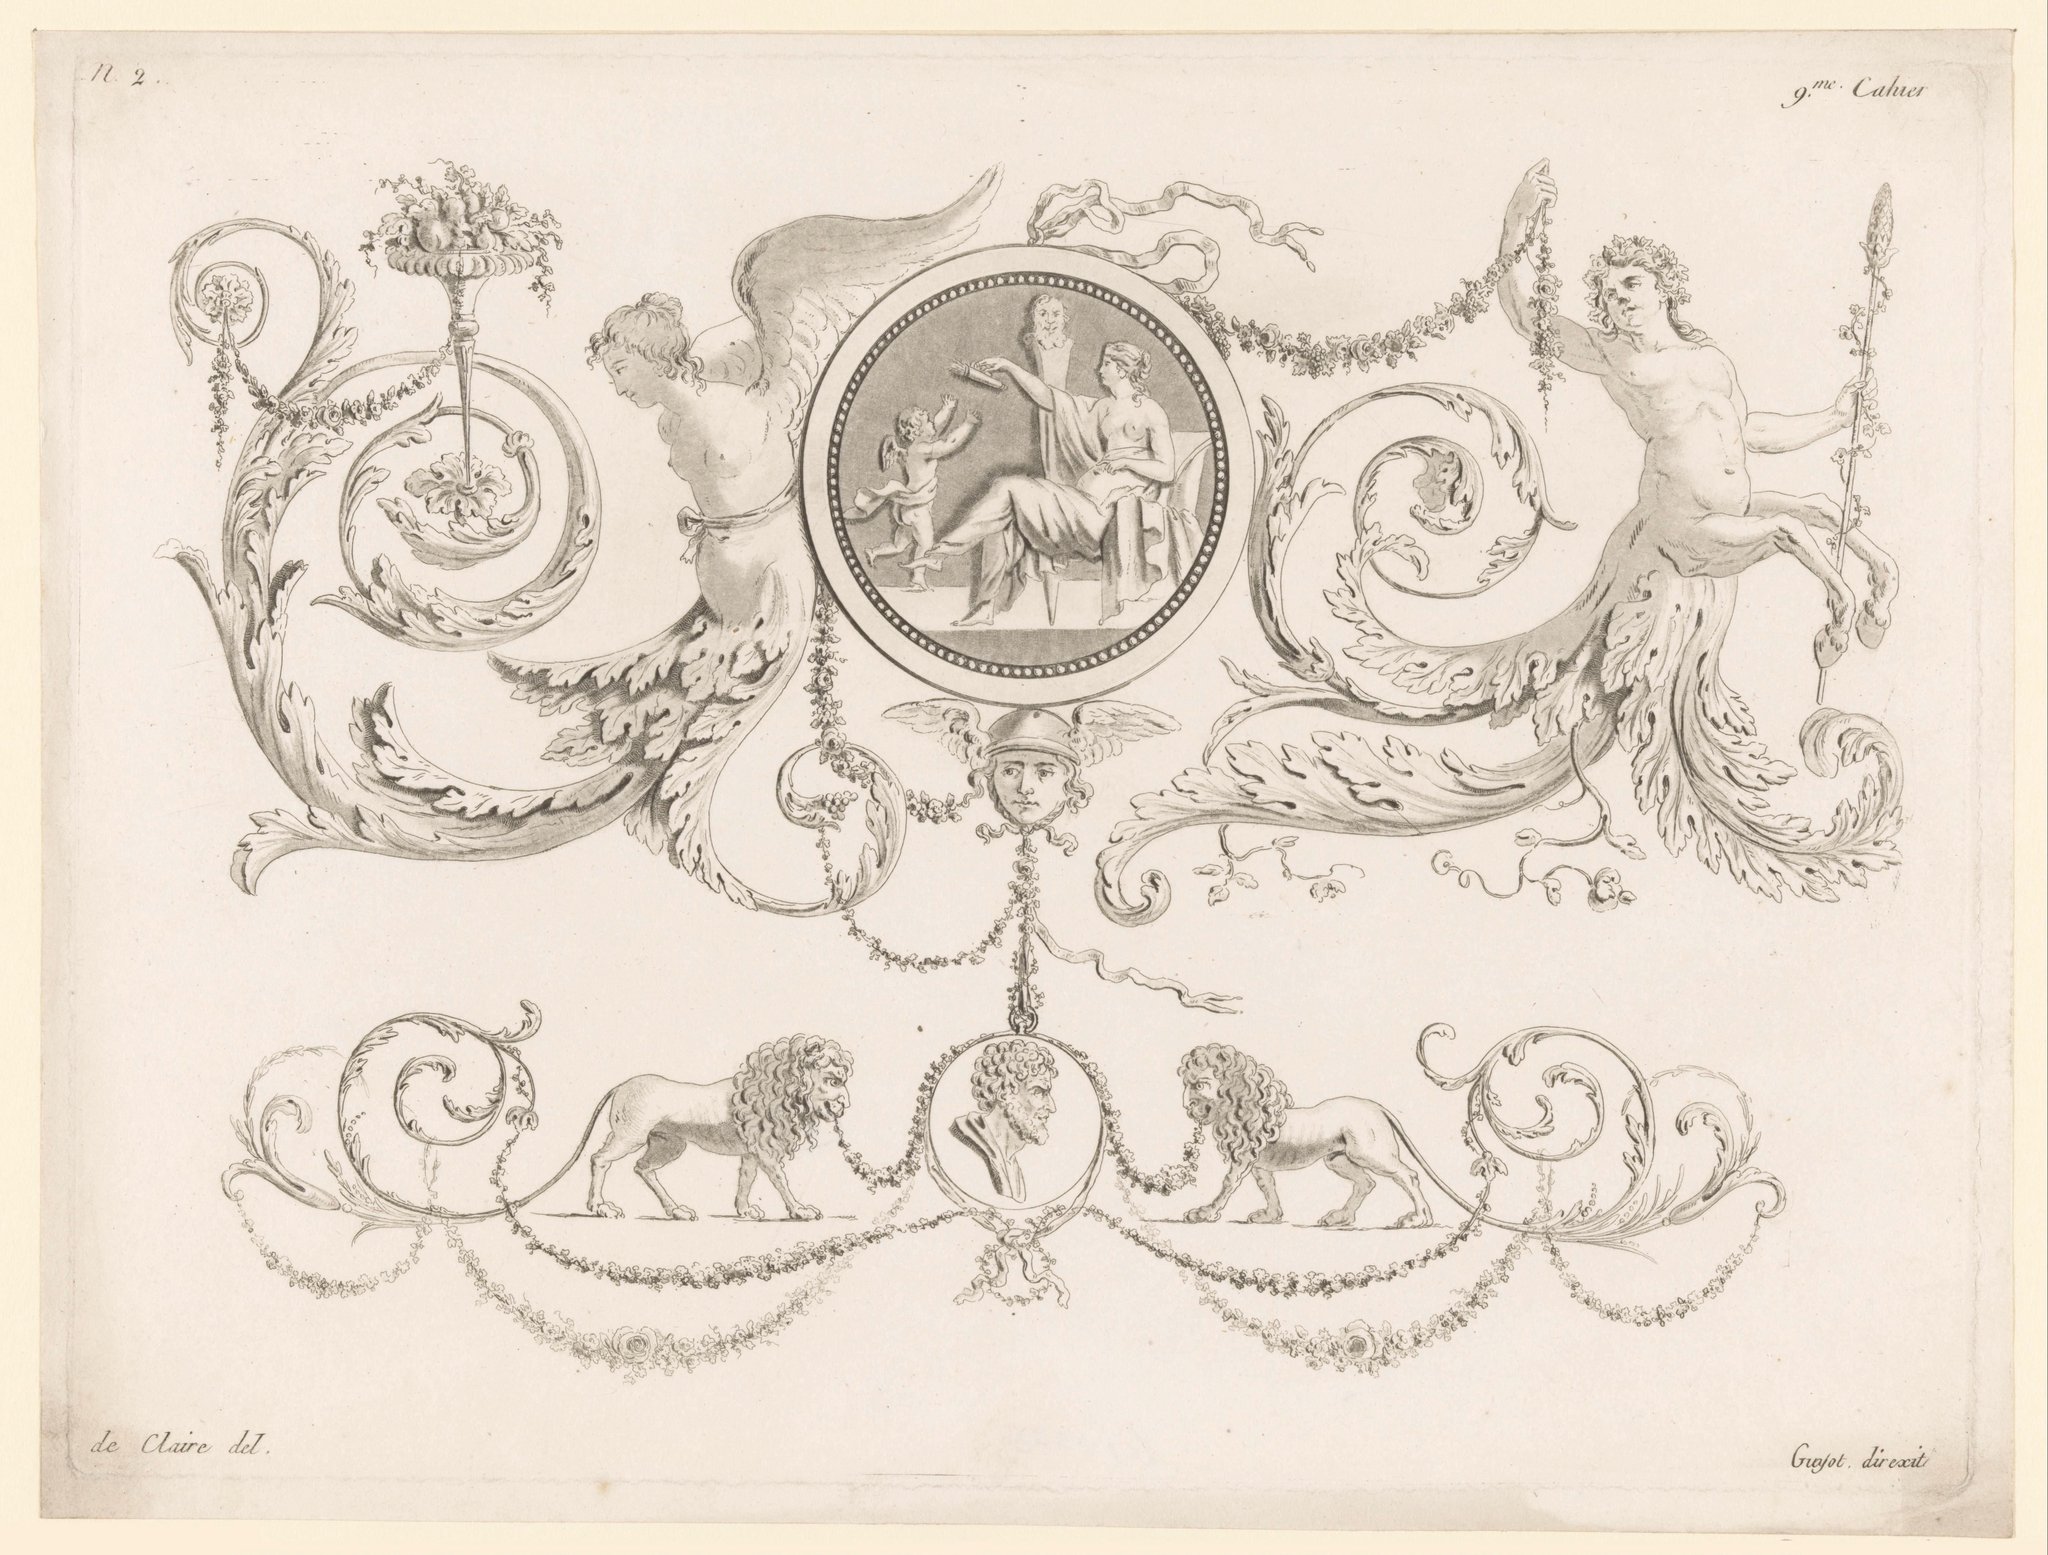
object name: print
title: Nouvelle Collection D'Arabesques, Propres A La Décoration Des Apartemens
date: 1810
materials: paper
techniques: aquatint, etching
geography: paris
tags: ornament ~ arabesque, ornament ~ medallion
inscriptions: collector's mark: Lugt 2228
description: Arabesken met een vrouwelijk halffiguur met vleugels en een mannelijk halffiguur met paardenbenen en een thyrsus aan weerszijden van een rond medaillon met een zittende vrouw en putto. Daaronder arabesken met een gezicht met gevleugelde helm en twee leeuwen aan weerszijden van een medaillon met mannenportret en profil.